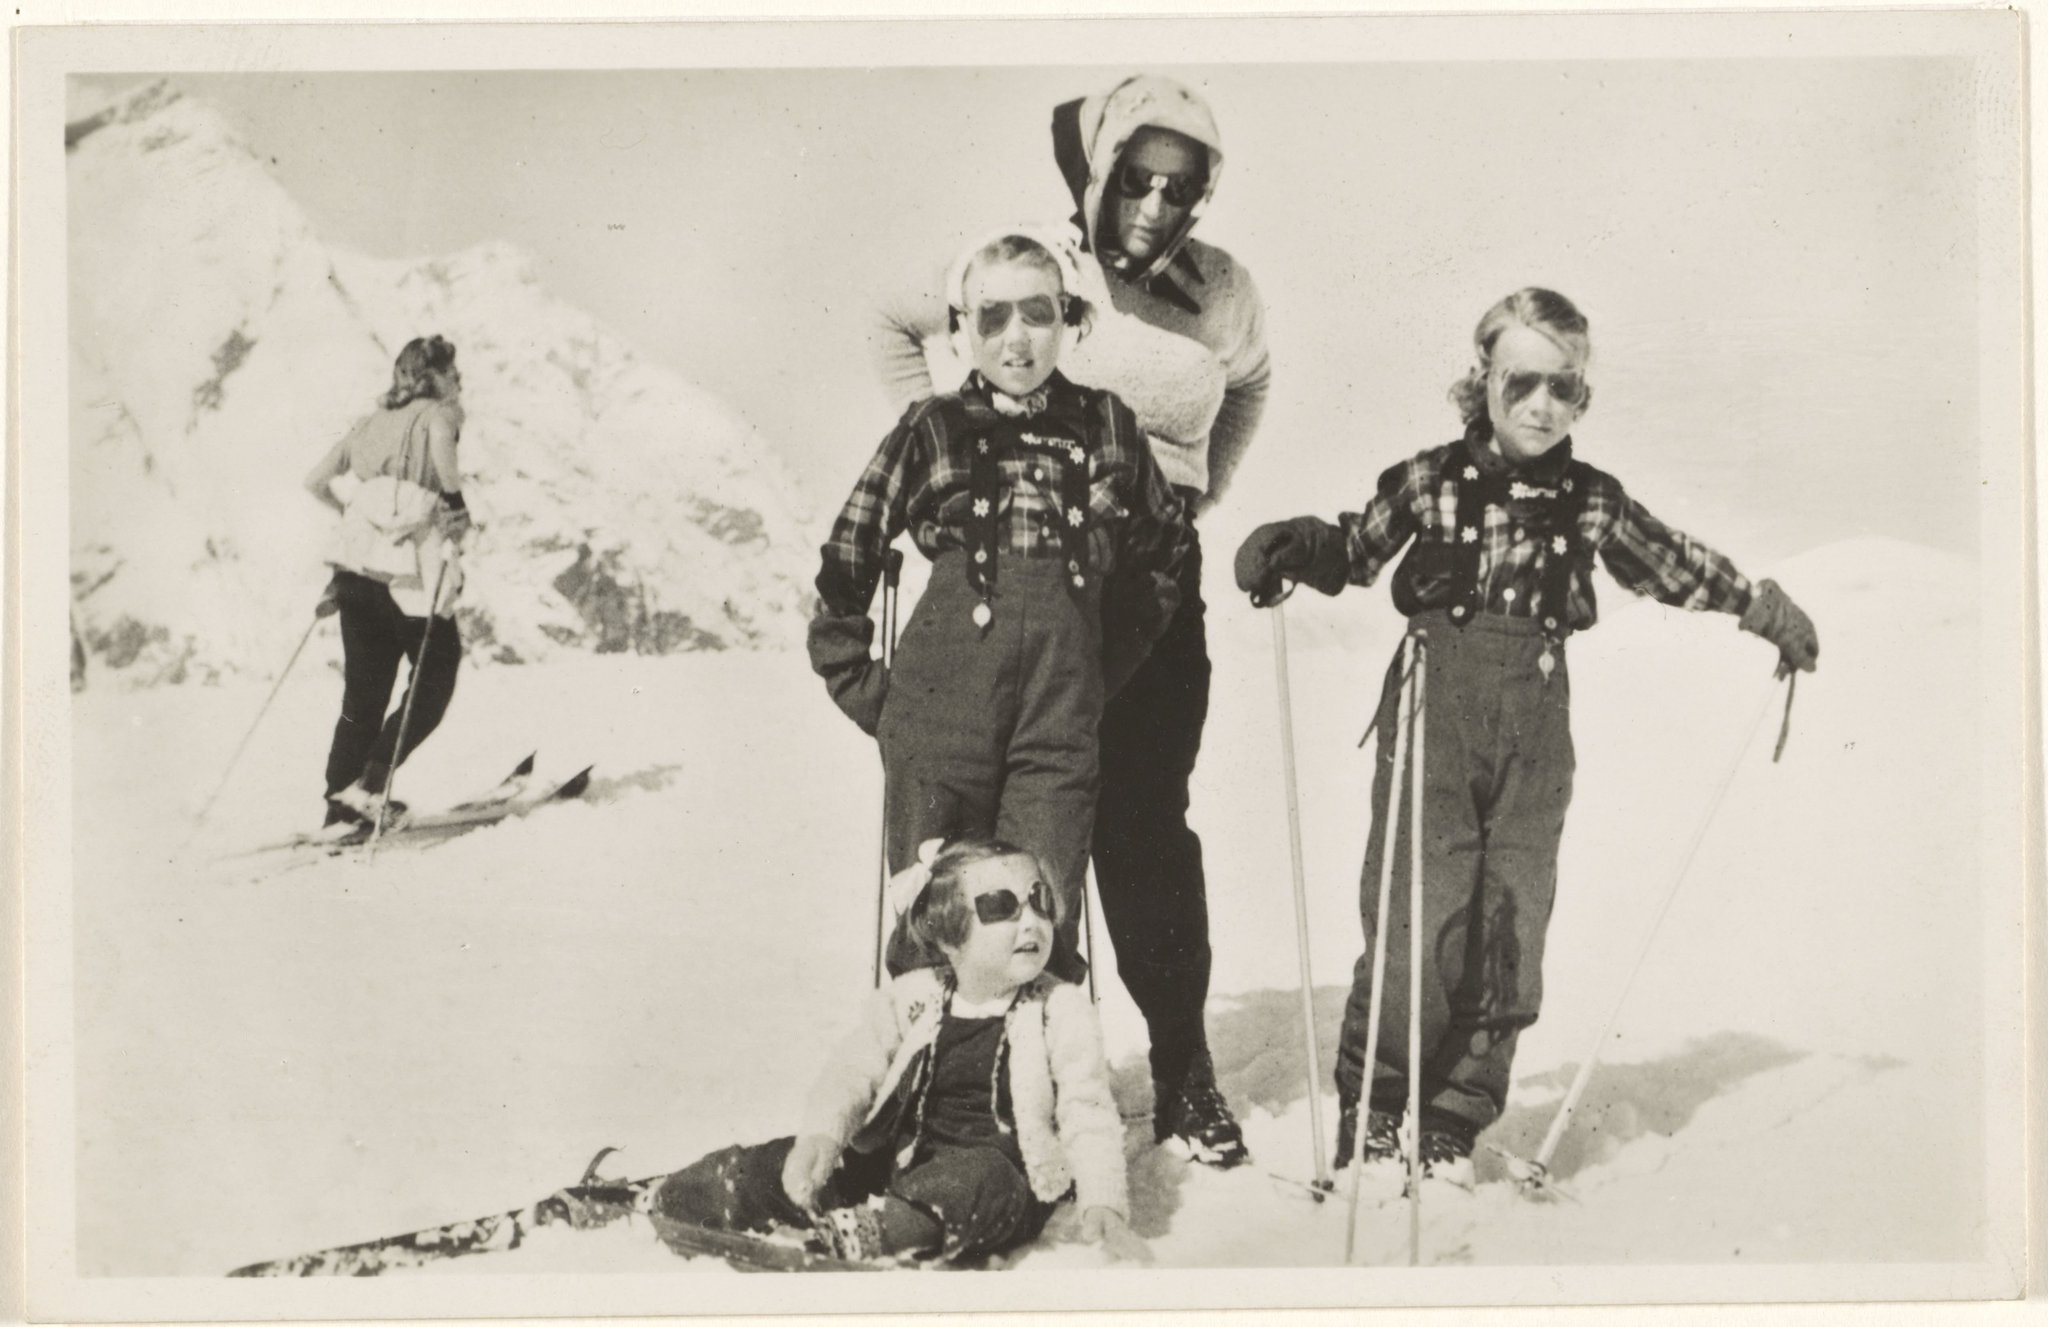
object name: photograph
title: Portret van Juliana, koningin der Nederlanden, Beatrix, koningin der Nederlanden, Irene, prinses der Nederlanden, en Margriet, prinses der Nederlanden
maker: Anonymous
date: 1947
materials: photographic support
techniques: photography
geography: amsterdam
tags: beatrix (koningin der nederlanden), juliana of the netherlands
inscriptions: date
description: De hier vermelde titel verwijst naar de hoogst verkregen titel van de geportretteerde, niet per se naar de titel die de geportretteerde op deze voorstelling draagt.